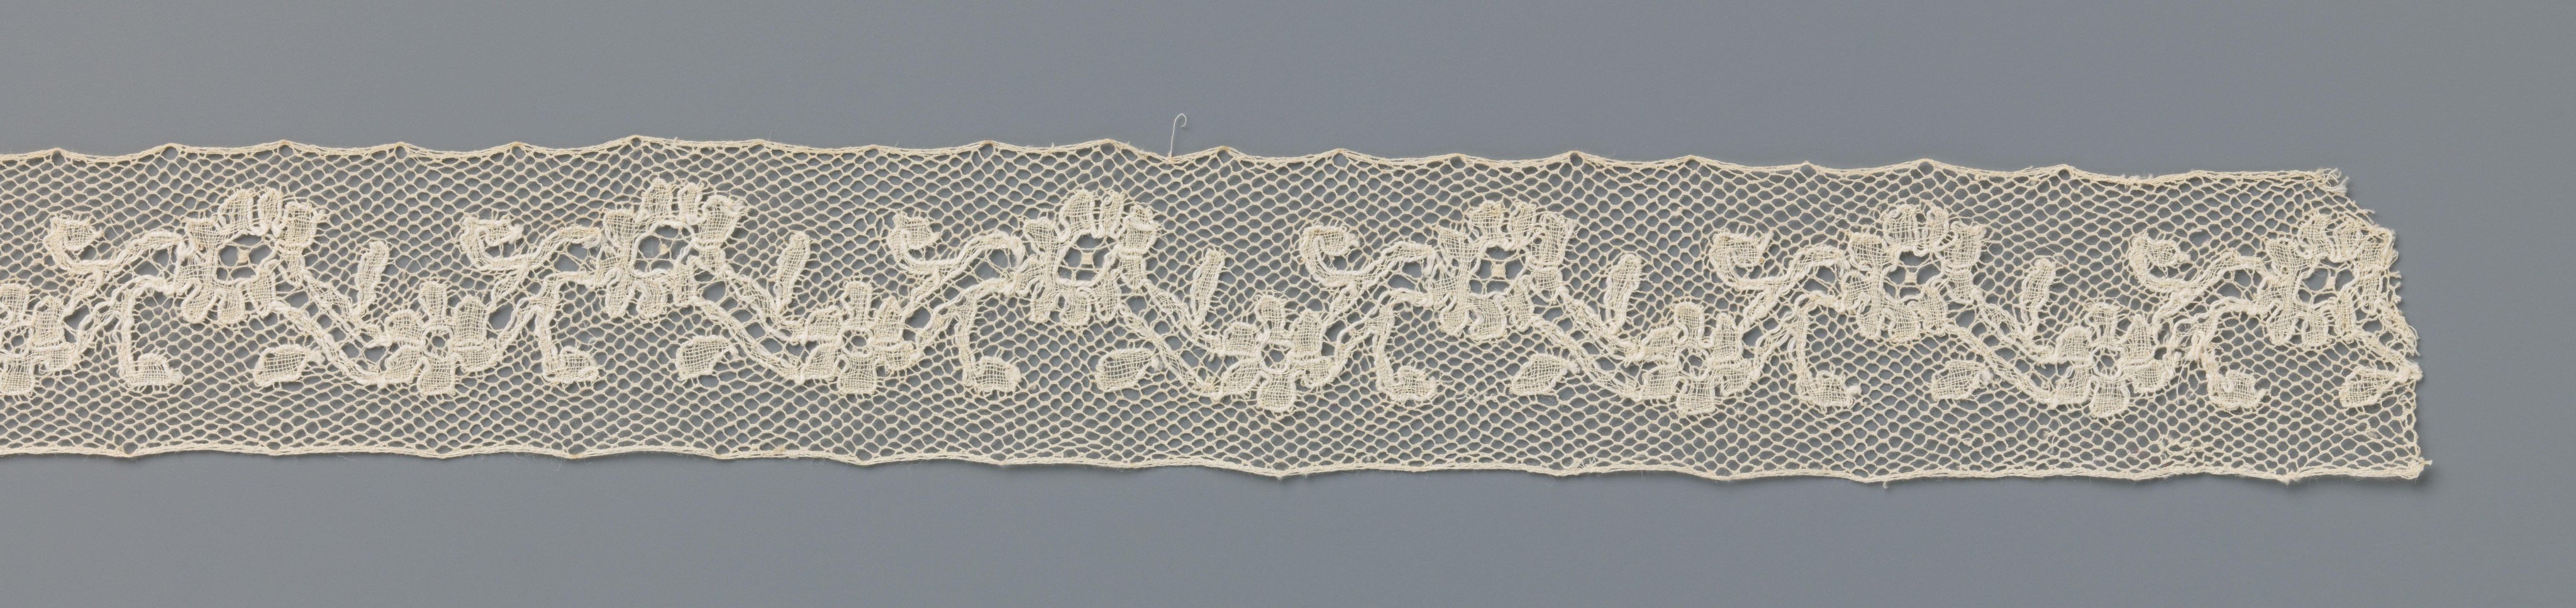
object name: entre deux, tussenzetsel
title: Tussenzetsel van kloskant met zigzaglijn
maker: Anonymous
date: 1875-1949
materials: linen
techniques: lace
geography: belgium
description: Tussenzetsel van naturelkleurige kloskant: Mechelse kant. In het midden van de fijne traliegrond, een Mechelse grond (ook wel ijsgrond genoemd), loopt een opengewerkte band in zigzaglijn, oversneden door twee soorten rozetjes.